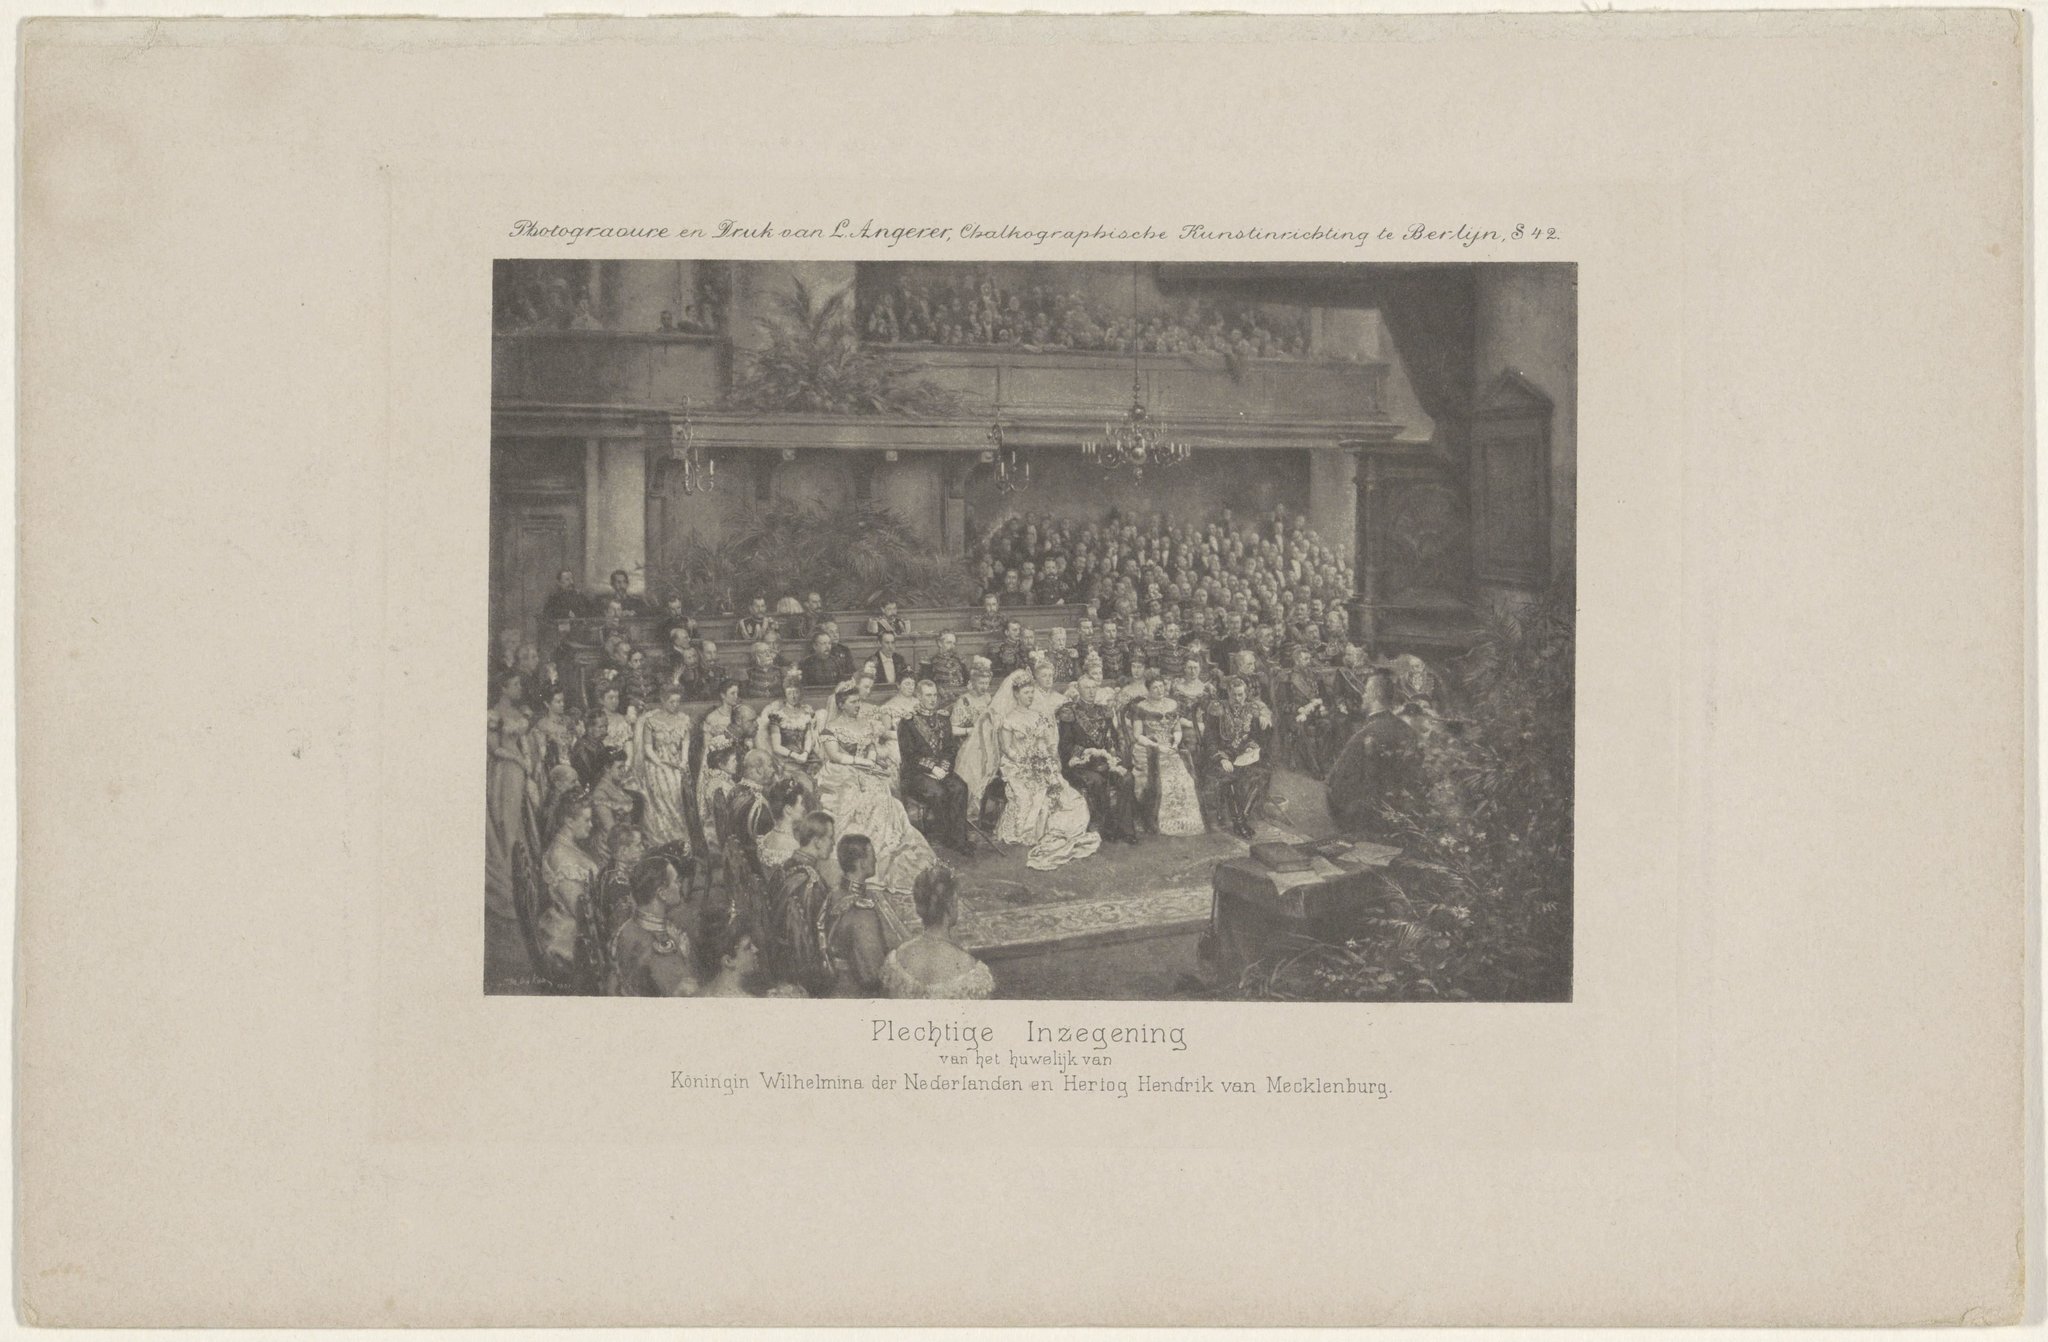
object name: print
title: Plechtige Inzegening van het huwelijk van Koningin Wilhelmina der Nederlanden en Hertog Hendrik van Mecklenburg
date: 1901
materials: paper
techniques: photoaquatint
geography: netherlands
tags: the hague, print maker, wilhelmina of the netherlands, hendrik (prins der nederlanden (1876-1934)), emma (queen consort of the netherlands), civil marriage ceremony, marriage ~ protestant service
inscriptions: collector's mark: Lugt 2228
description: Inzegening van het huwelijk van Koningin Wilhelmina hertog Hendrik van Mecklenburg in de Grote Kerk te 's-Gravenhage op 7 februari 1901. Links van de bruid haar moeder koningin Emma en Hendriks neef groothertog Frederik Frans IV van Mecklenburg-Schwerin. Rechts van de bruidegom zijn moeder Marie van Schwarzburg-Rudolstadt. Het huwelijk werd voltrokken door minister van Justitie Pieter Wilhelm Adrianus Cort van der Linden, die voor de gelegenheid optrad als ambtenaar van de burgerlijke stand.